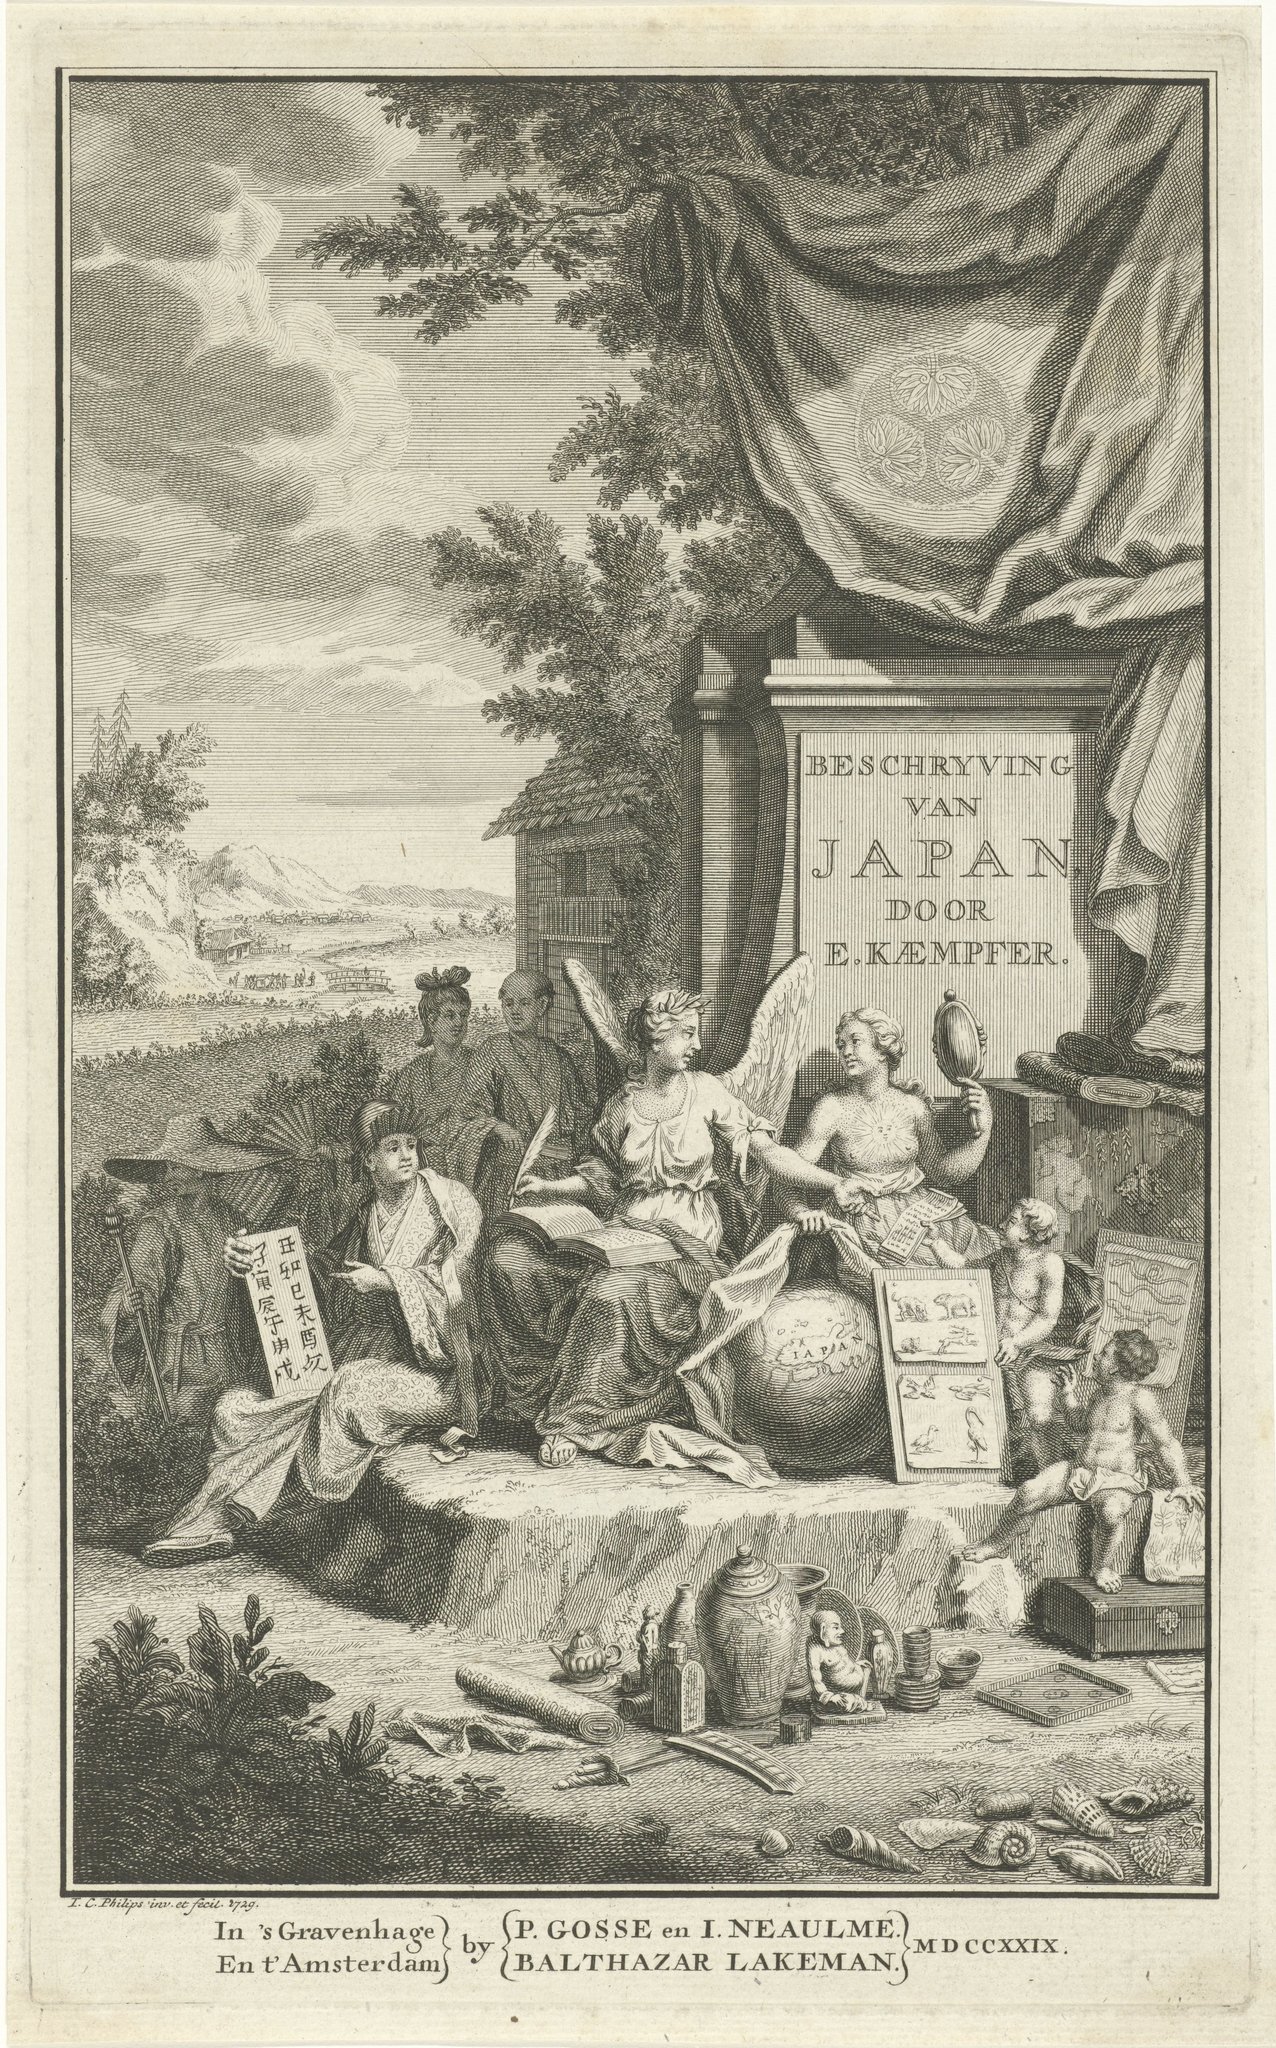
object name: titelblad, titelpagina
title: Titelpagina voor: E. Kaempfer, Beschryving van Japan, 1729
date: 1729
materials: paper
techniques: engraving, etching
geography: the hague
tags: truth; 'verità' (ripa), japanese, 'historia'; 'historia' (ripa)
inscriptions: collector's mark: Lugt 2228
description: Landschap met Geschiedenis, die met een veer in haar boek schrijft, en de Naakte Waarheid, die de wereldbol ter hoogte van Japan toont. Zij worden vergezeld door twee putti met studiebladen van de Japanse flora en fauna. Op de voorgrond Japanse vazen, beelden, gebruiksvoorwerpen en schelpen. Links op de achtergrond Japanse mannen en vrouwen en een traditioneel Japans dorp. Rechts op de achtergrond een monument waarop de titel in het Nederlands.